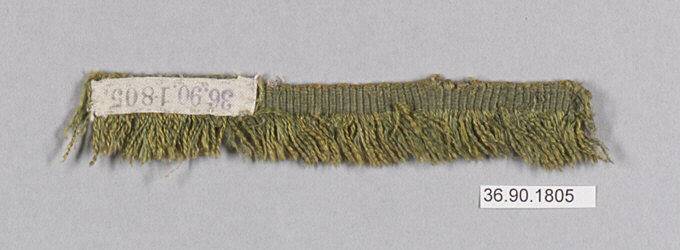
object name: fringe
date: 1867-1900